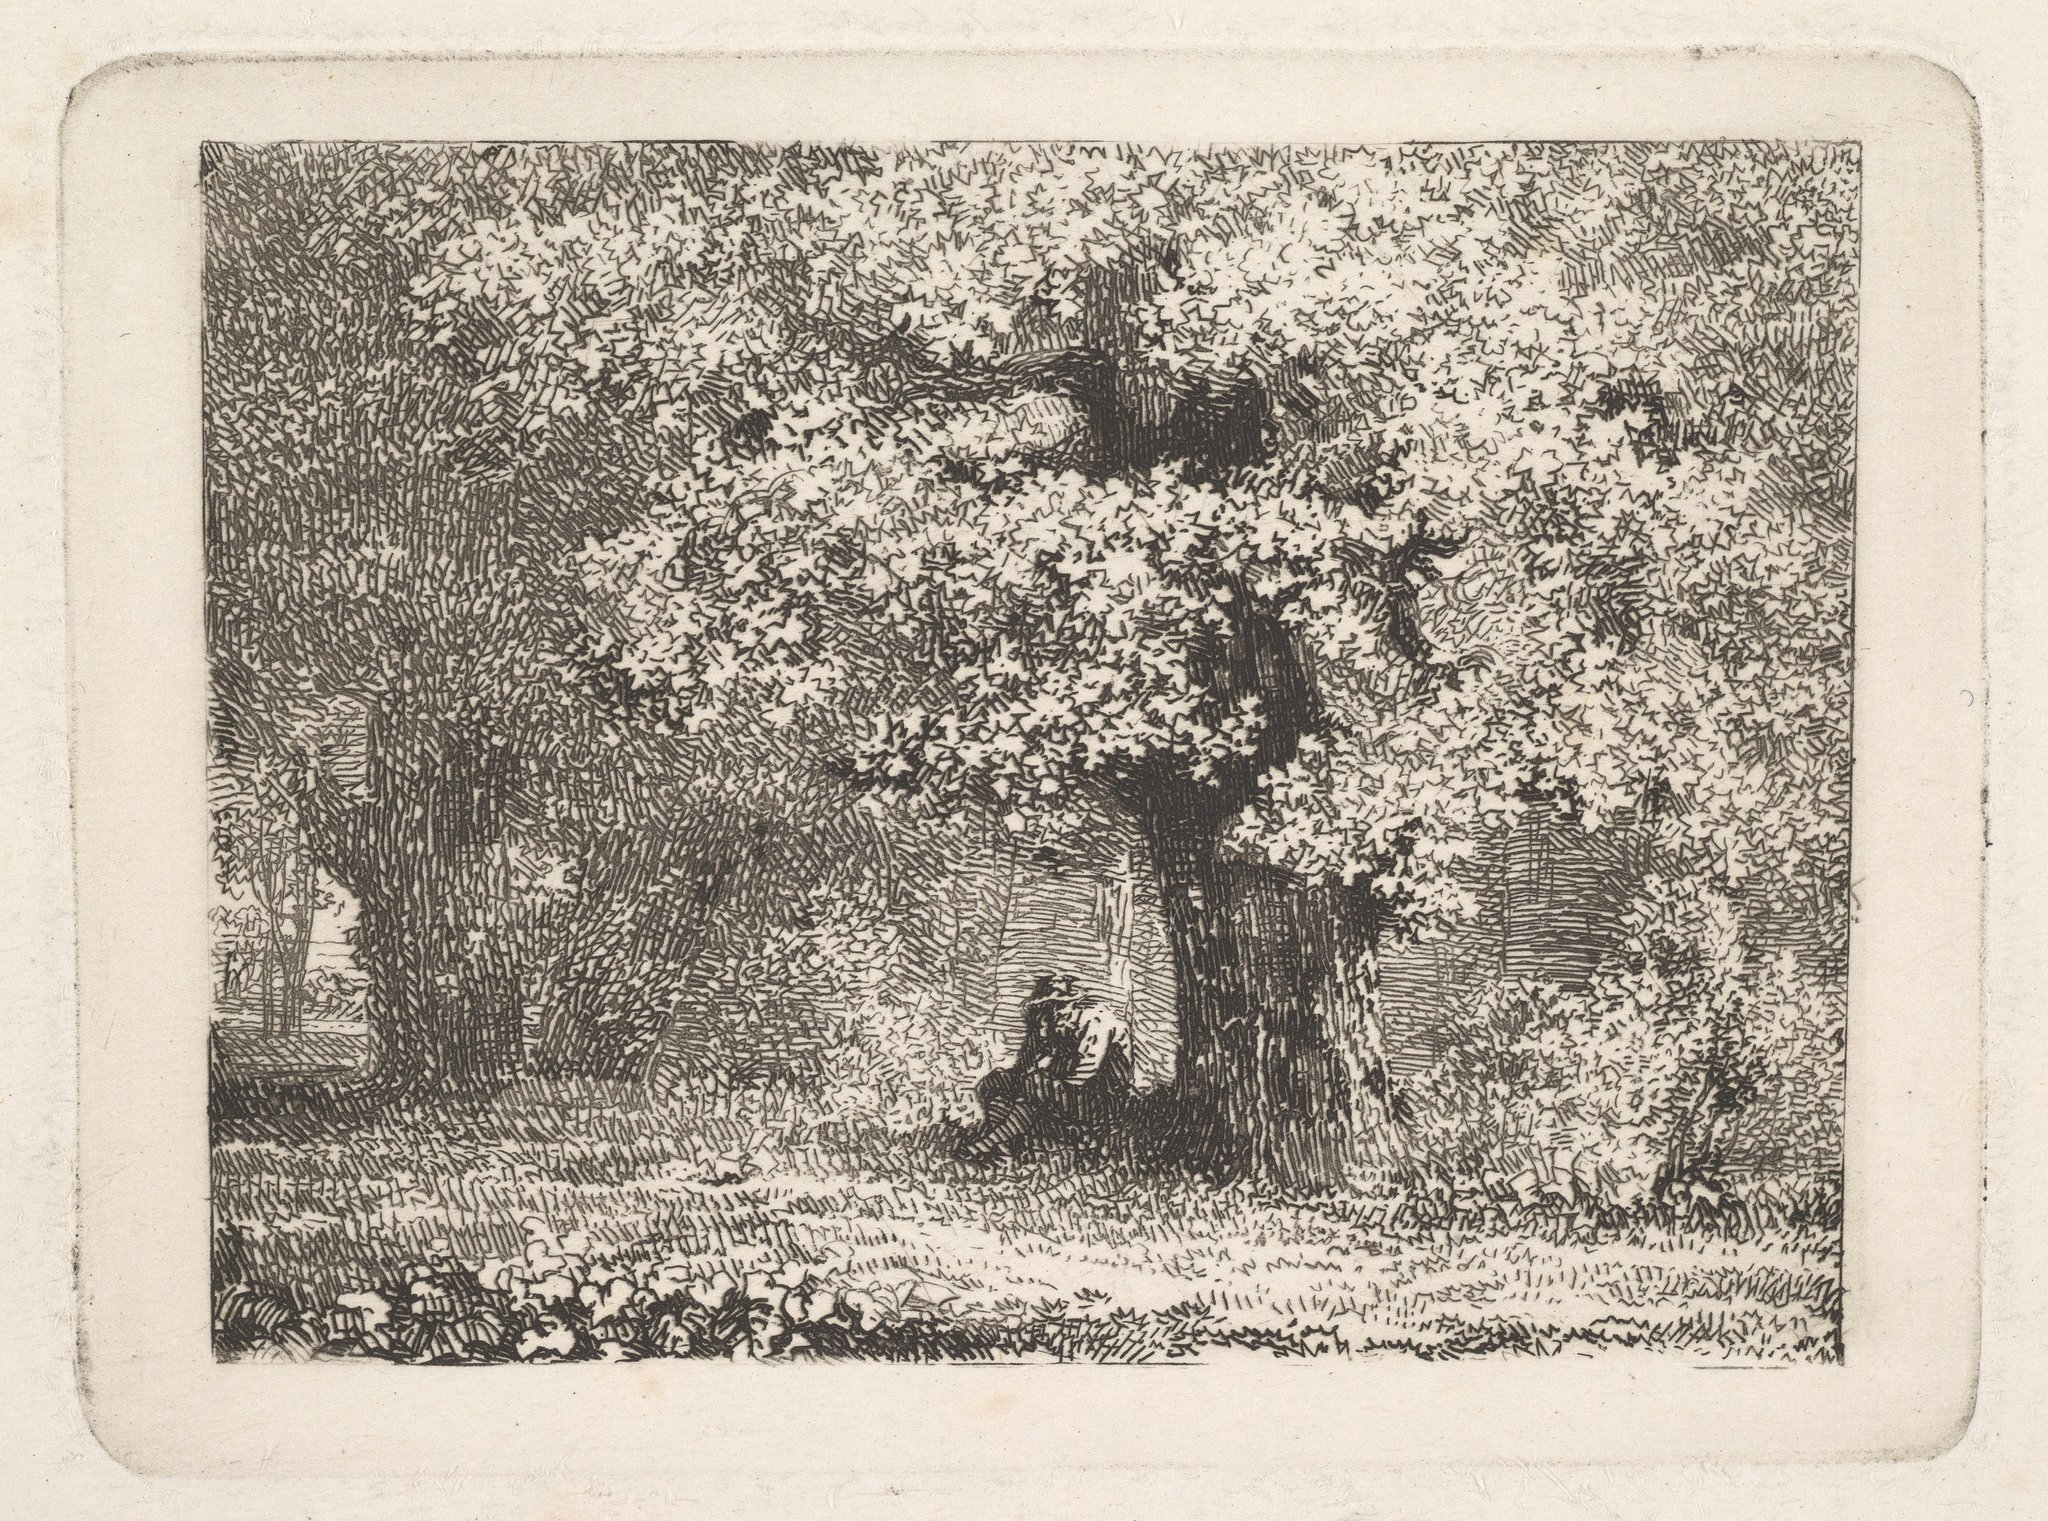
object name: print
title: A Man Sitting under a Tree in Bloom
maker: johann christoph erhard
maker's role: artist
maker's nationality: german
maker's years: 1795-1822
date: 1801-1900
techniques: etching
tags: men,trees